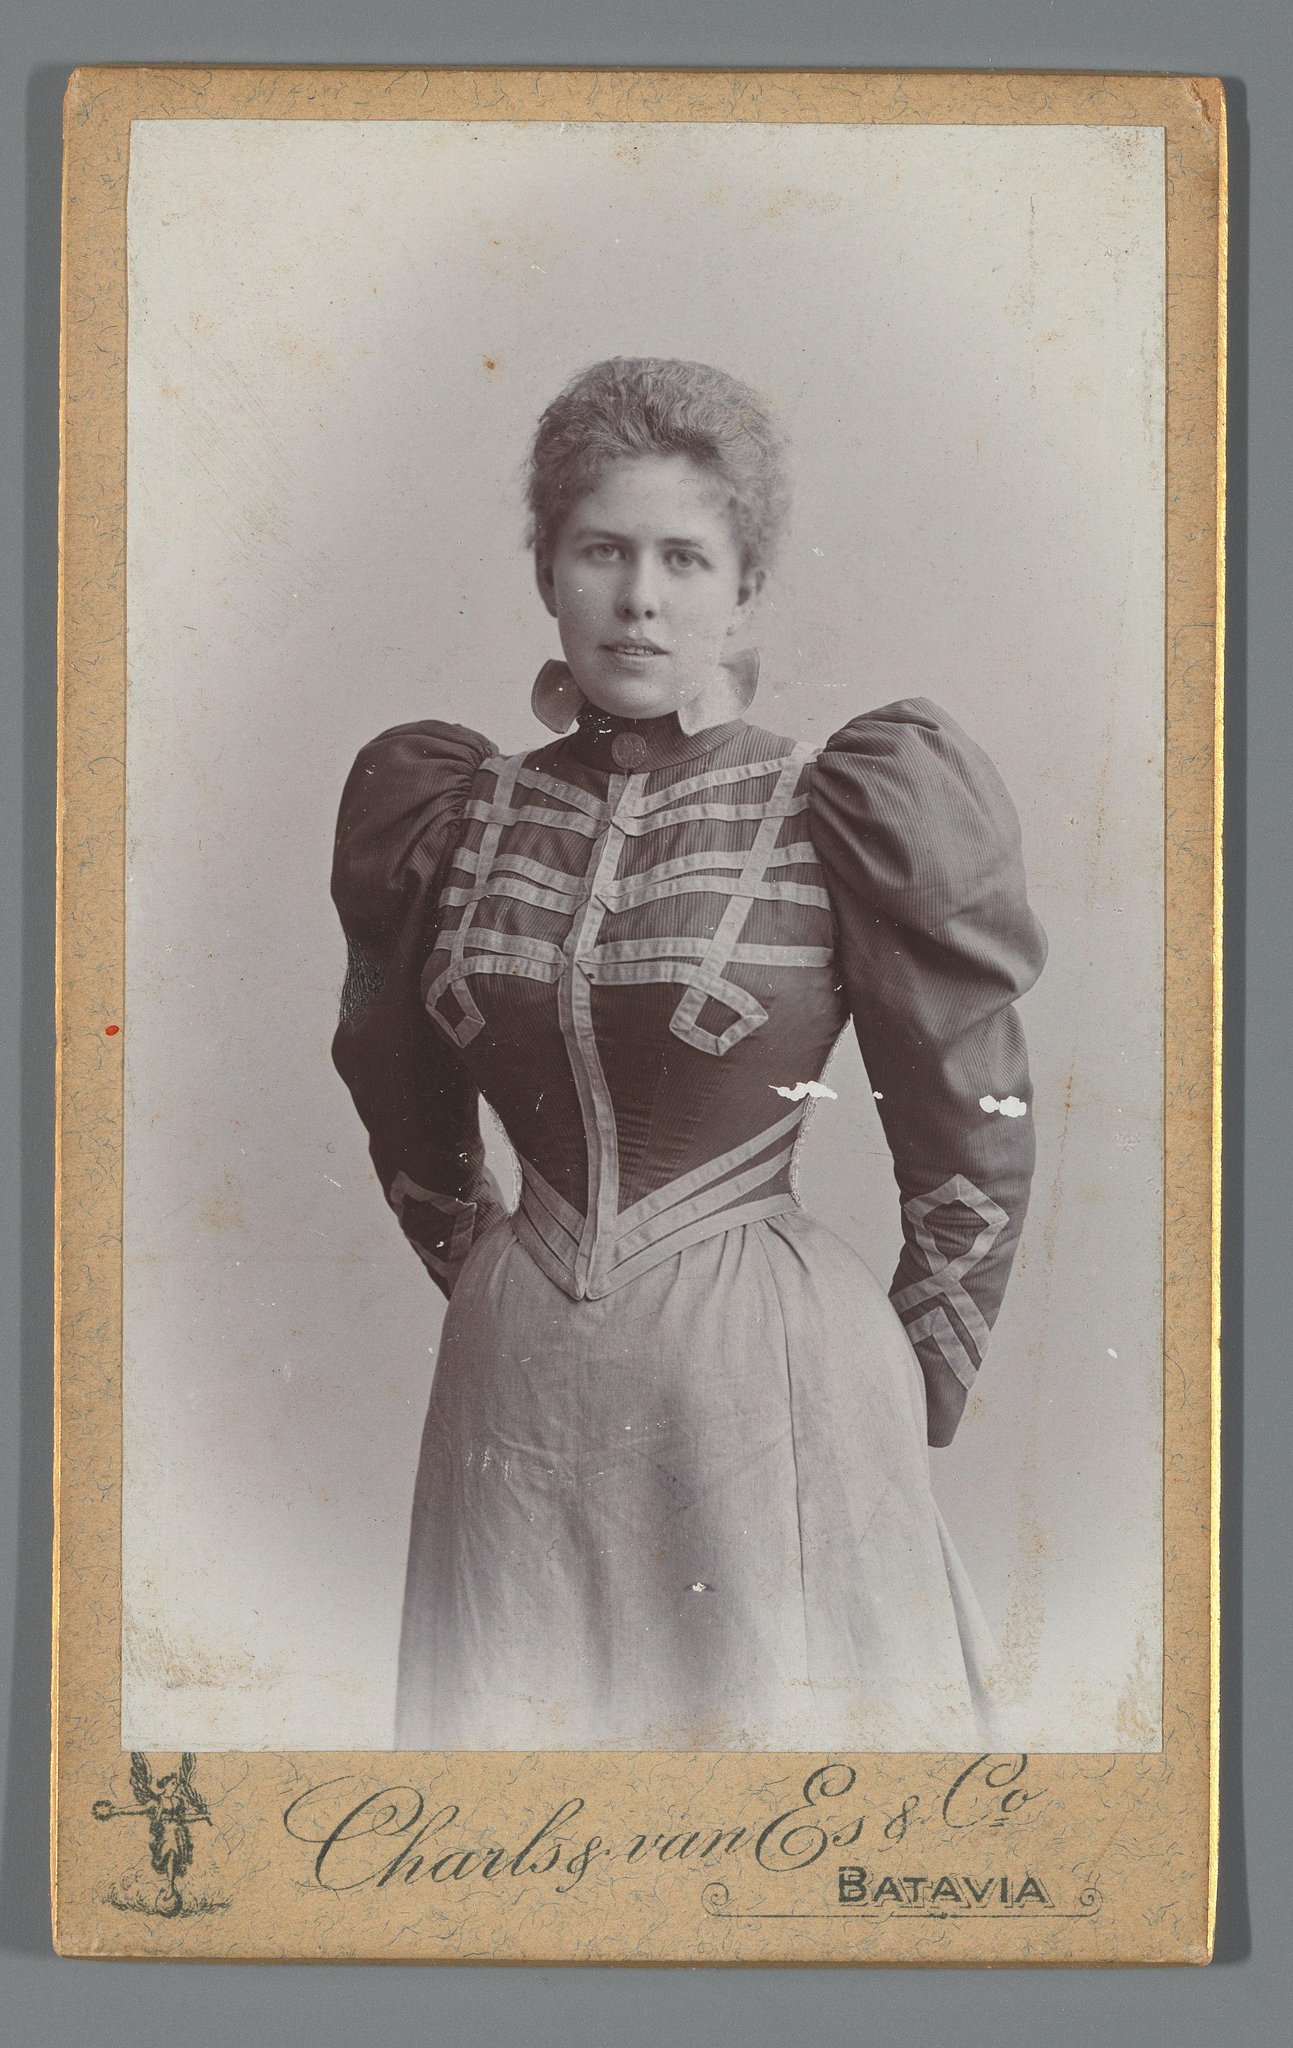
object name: carte de visite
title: Studioportret van Poppy Dunlop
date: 1890-1910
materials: cardboard, photographic support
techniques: albumen print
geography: batavia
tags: amsterdam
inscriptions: name: ‘CHARLS & VAN ES & Co / BATAVIA’, name: ‘tante Poppy’